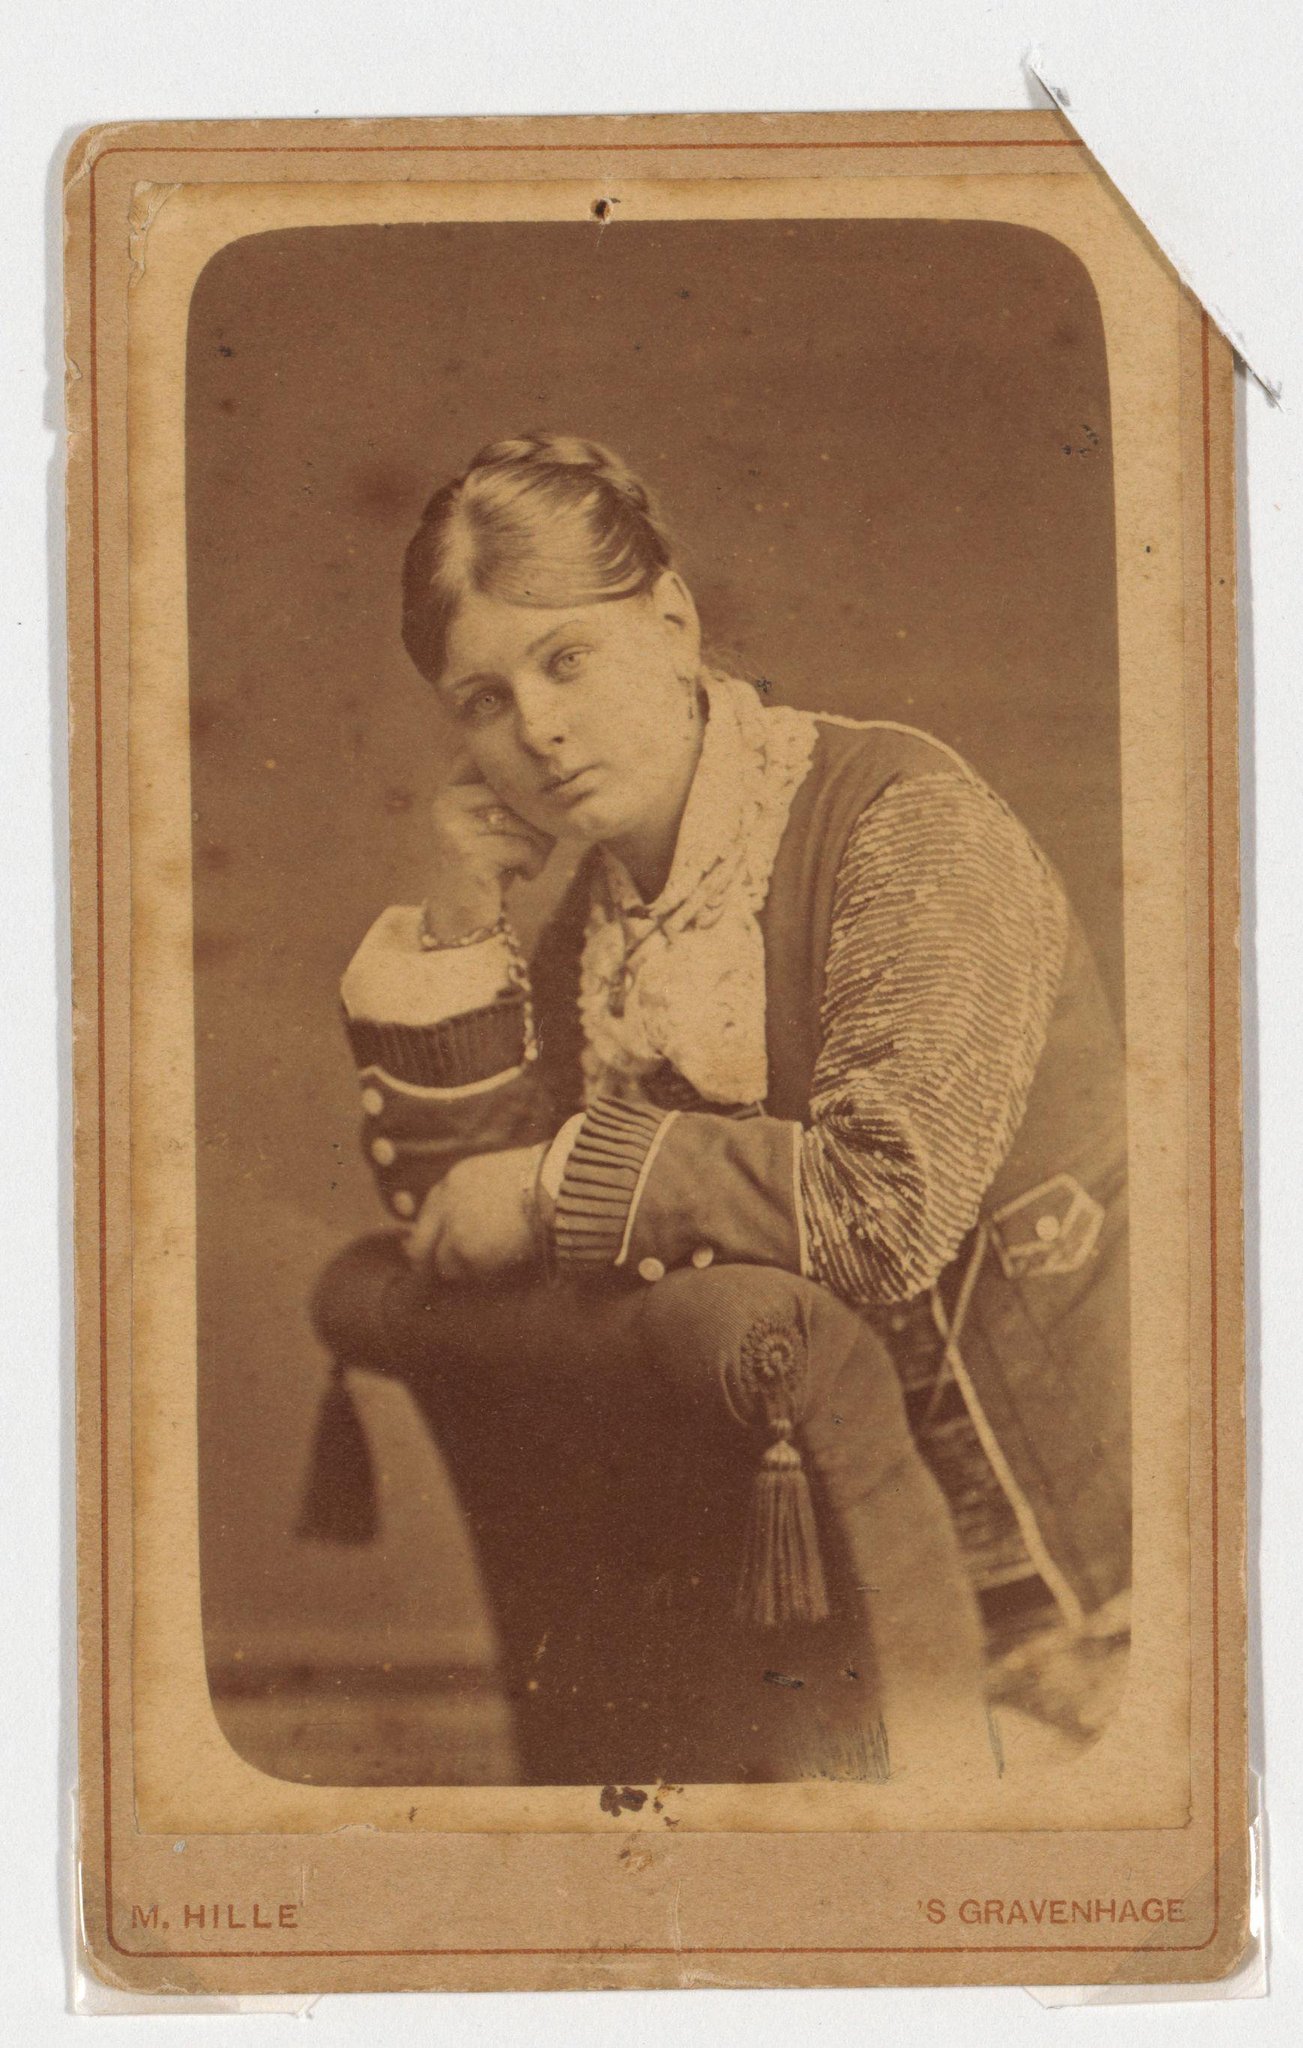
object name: photograph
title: Portret van een vrouw, leunend op een fauteuil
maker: maria hille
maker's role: fotograaf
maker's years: 1827-1893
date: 1868-1880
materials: cardboard, paper, photographic support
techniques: albumen print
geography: the hague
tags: studio requisites ~ photographer, historical persons not known by name - bb - woman, the hague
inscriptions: address: ‘'s Gravenhage 69 Dennenweg 69’